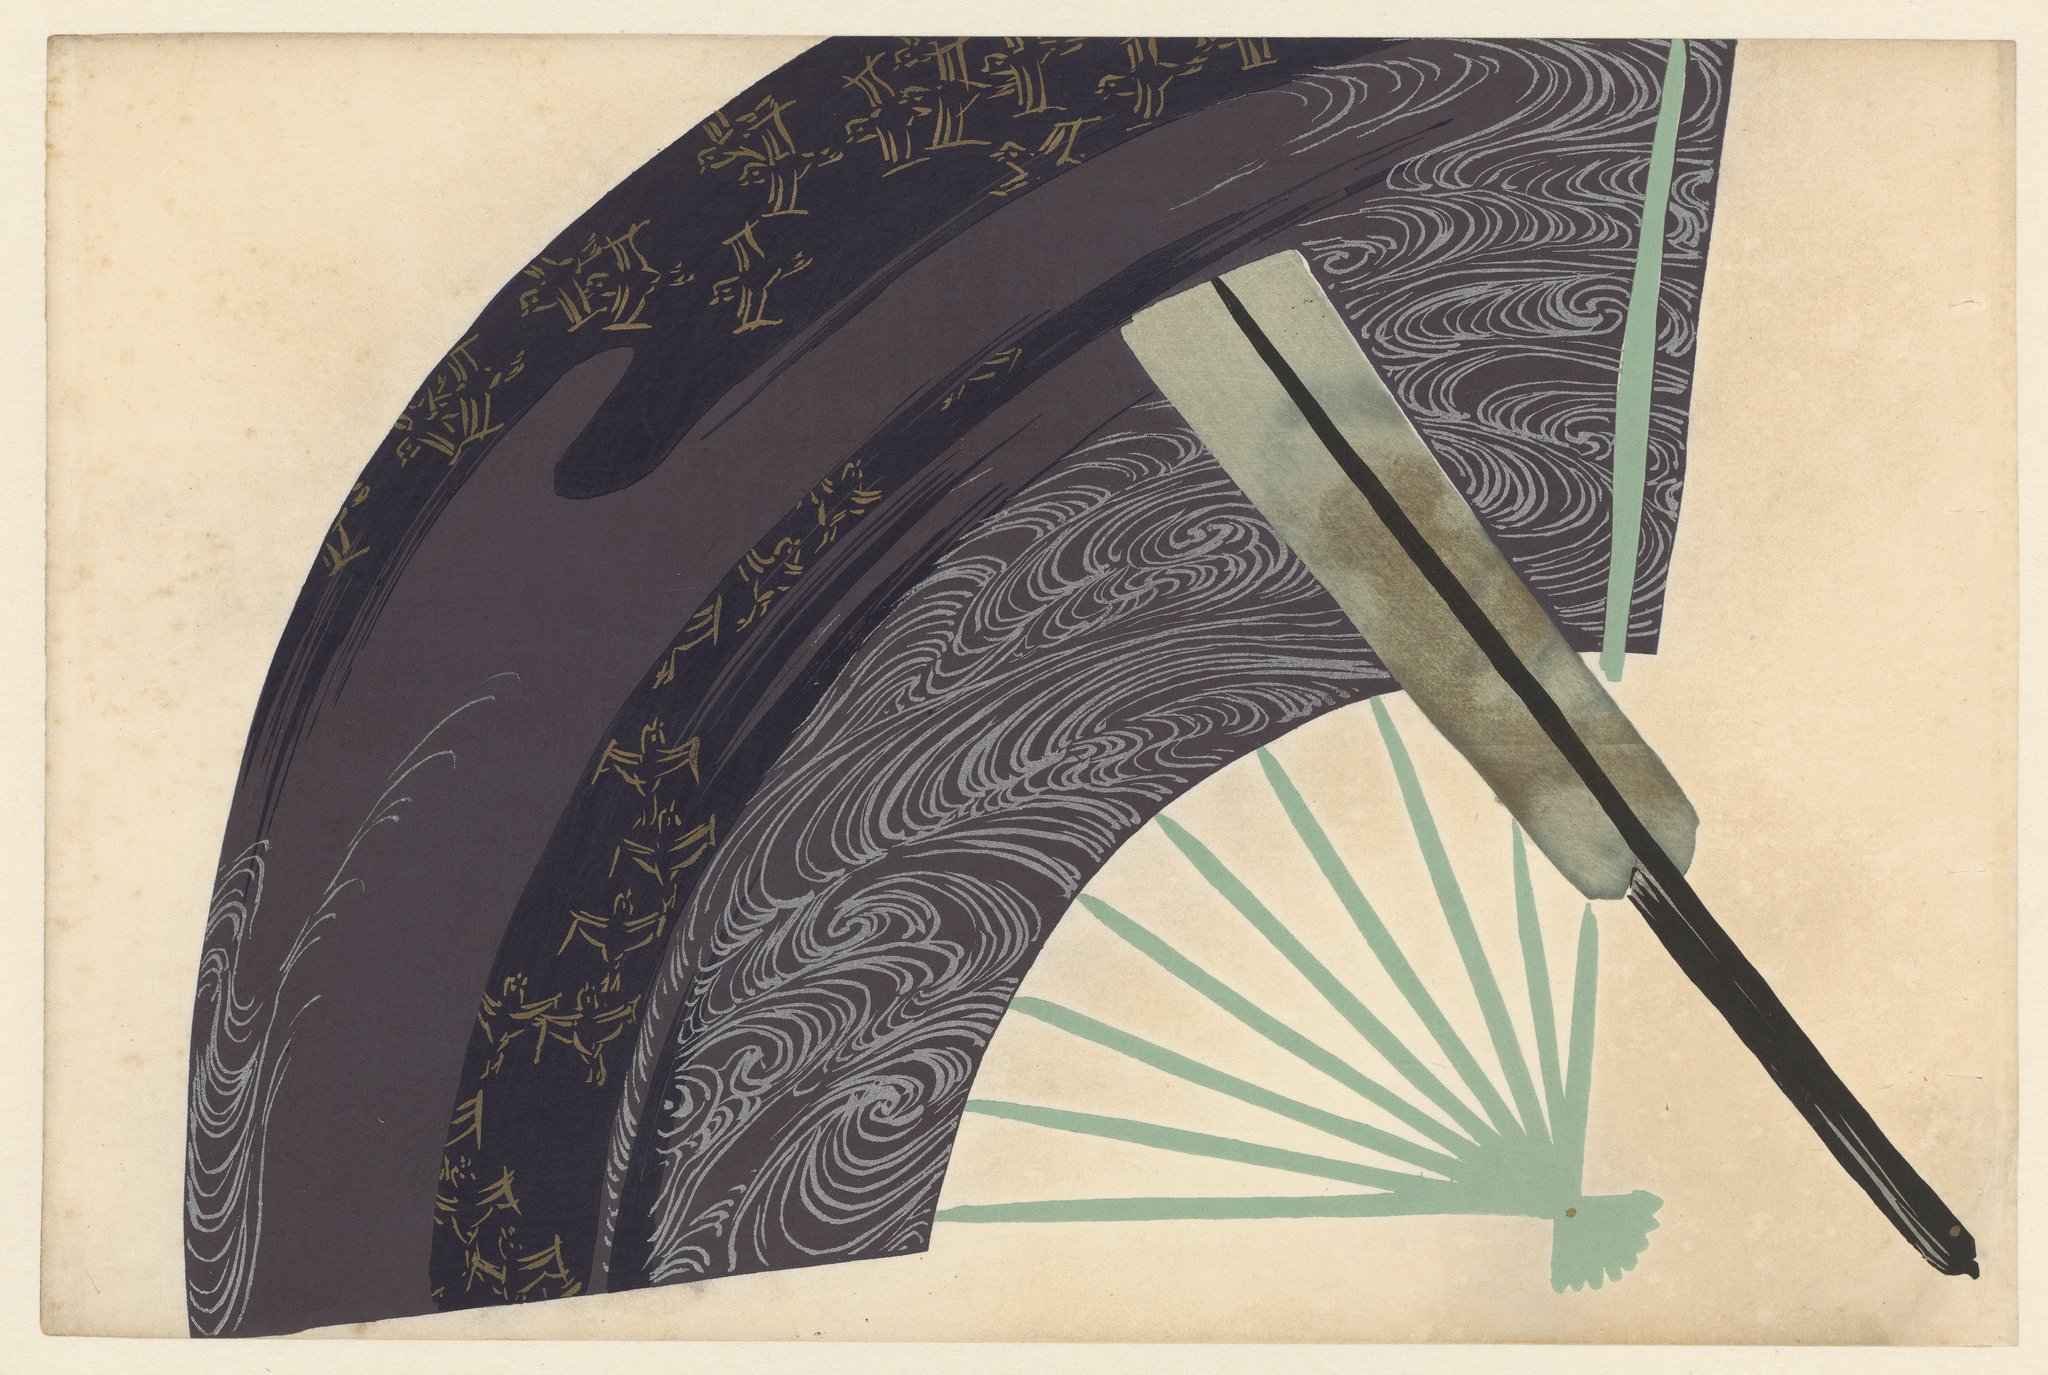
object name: print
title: Four Prints from the Series ‘Flowers of a Hundred Worlds’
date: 1909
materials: gold powder, paper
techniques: woodcut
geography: kyoto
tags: fan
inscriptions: collector's mark: Lugt 2228, collector's mark: Lugt 2760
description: The Rinpa School features stylized landscapes and motifs, with blocks of colour and in this instance without outlines. This style dates to the 17th century and was revived in a new form in the early 20th century. Sekka breathed new life into the movement. His designs profoundly influenced ceramics and lacquer in the 1900s to 1920s, especially in Kyoto.